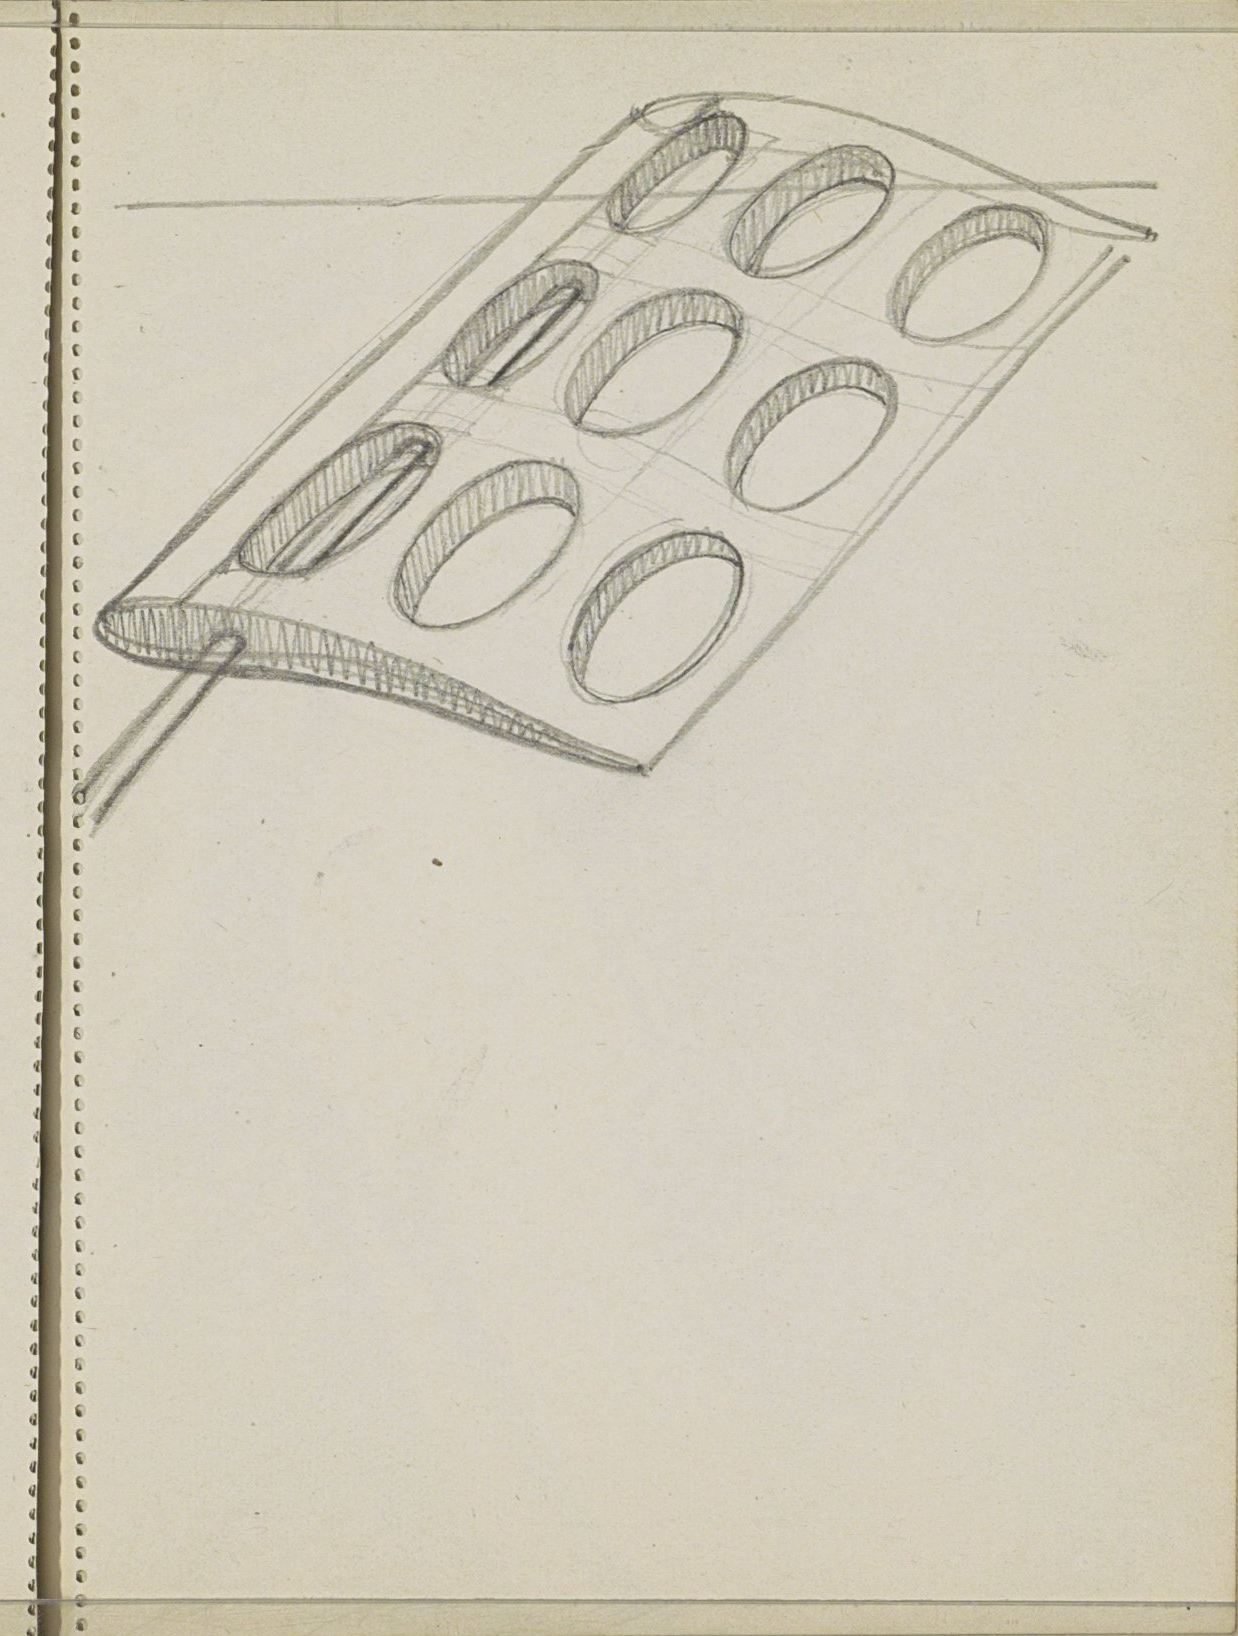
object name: sketchbook leaf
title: Studie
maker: reijer stolk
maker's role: draughtsman, print maker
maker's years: 1896-1945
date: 1906-1945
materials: paper, pencil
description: Langwerpig voorwerp met cirkelvormige gaten. Mogelijk een ontwerp. Blad 37 recto uit een schetsboek met 53 bladen.